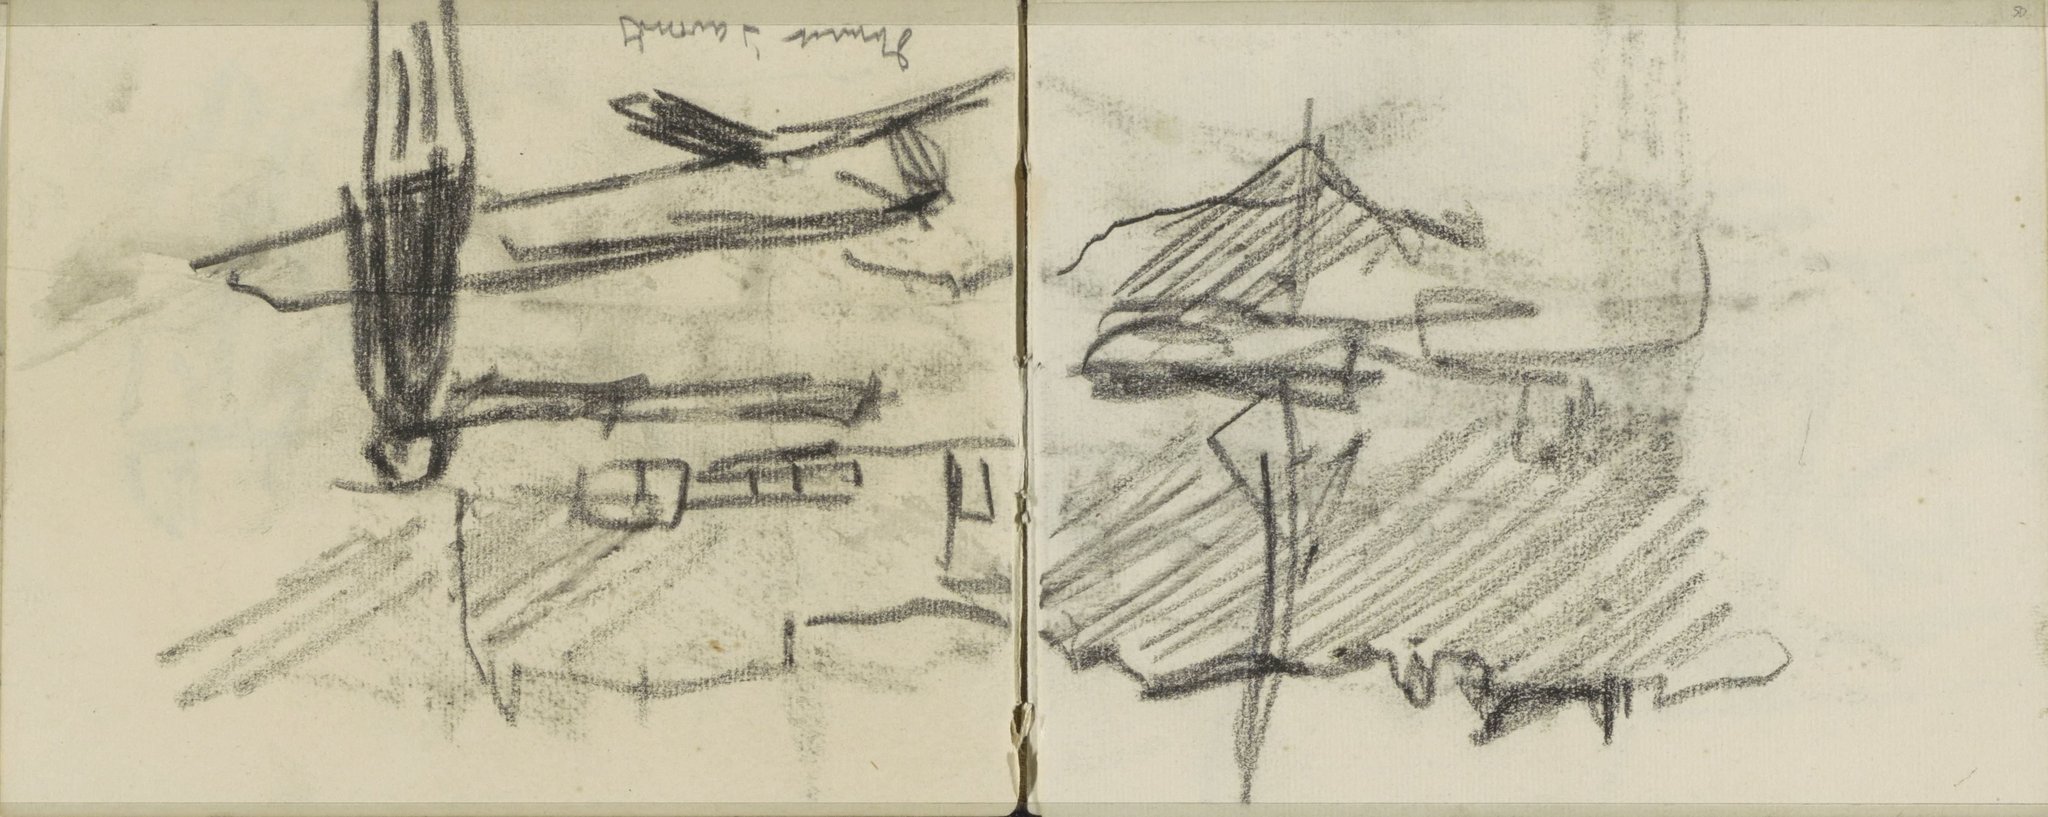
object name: sketchbook leaf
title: Gezicht op het Damrak te Amsterdam bij avond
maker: george hendrik breitner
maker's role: draughtsman, painter, print maker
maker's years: 1857-1923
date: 1893-1912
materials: chalk, paper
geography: amsterdam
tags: ships (in general), civic architecture; edifices; dwellings, canals, waters (in city) (+ city(-scape) with figures, staffage)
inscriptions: annotation: ‘Damrak 's avonds’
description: Vooraan een figuur. Pagina 49 en pagina 50 uit een schetsboek met 32 bladen.